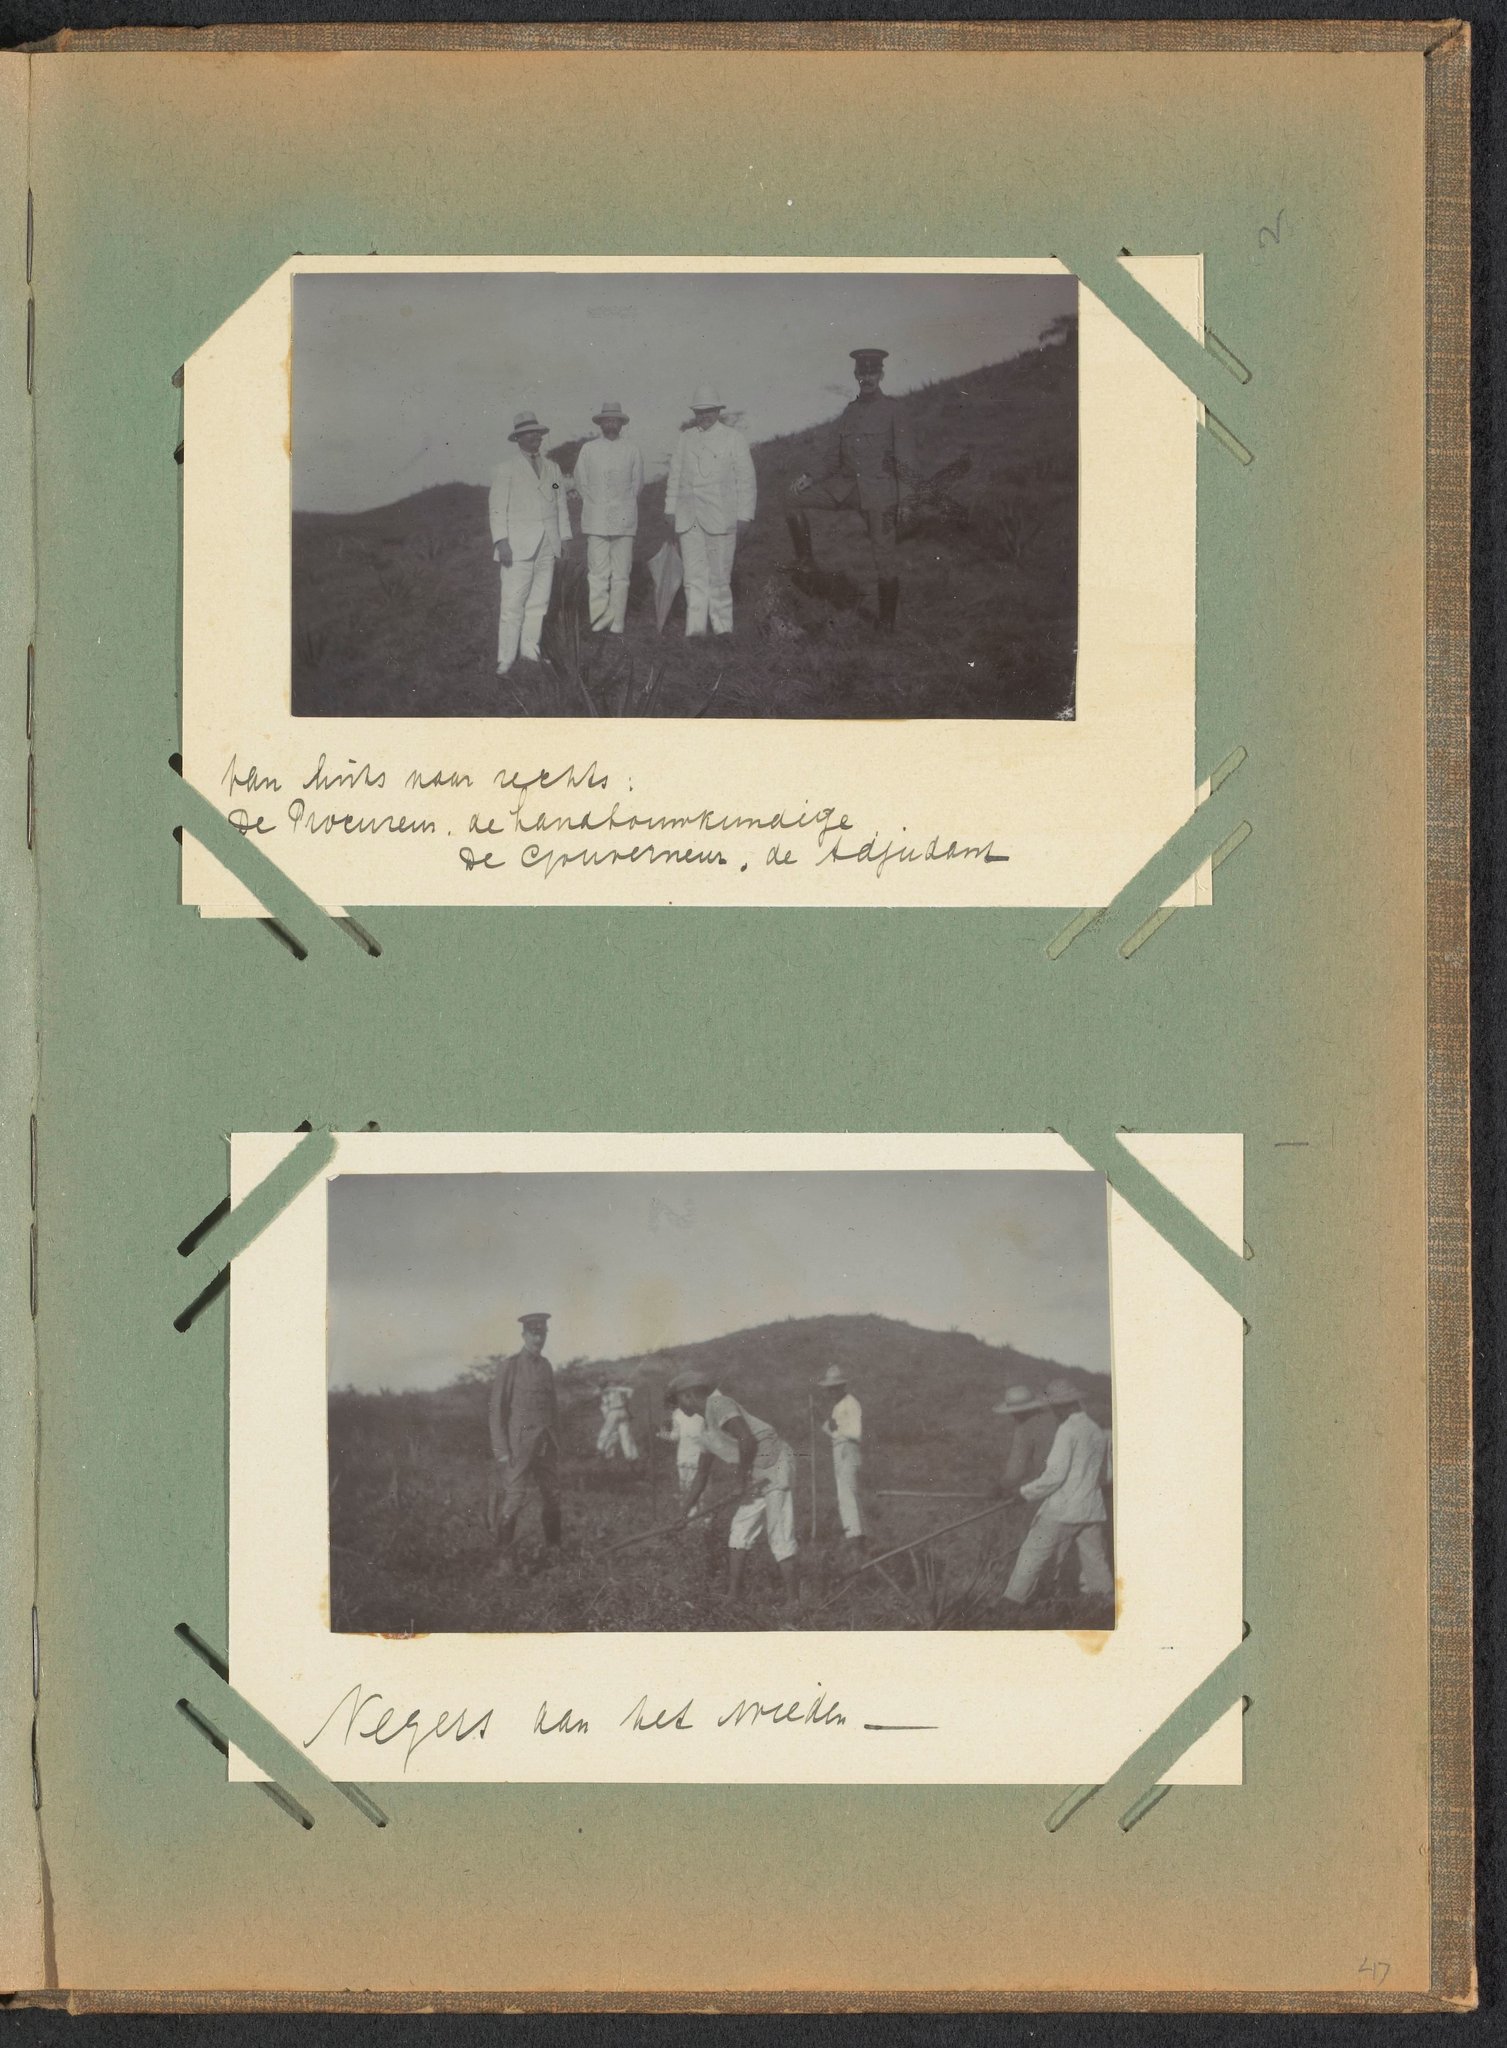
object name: photograph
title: Wieden van de sisalvelden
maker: Anonymous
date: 1912-1913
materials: paper, photographic support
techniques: gelatin silver print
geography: curacao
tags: plantation, (non-fruit) products of plants or trees: sisal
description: Arbeiders bezig met het wieden van de sisalvelden, tijdens het bezoek van de gouverneur aan de Plantage Mount Pleasant op Curaçao. Onderdeel van het fotoalbum uit ca. 1912-1913 met 92 foto's van de plantages Peperpot en Dordrecht in Suriname en Mount Pleasant op Curaçao.